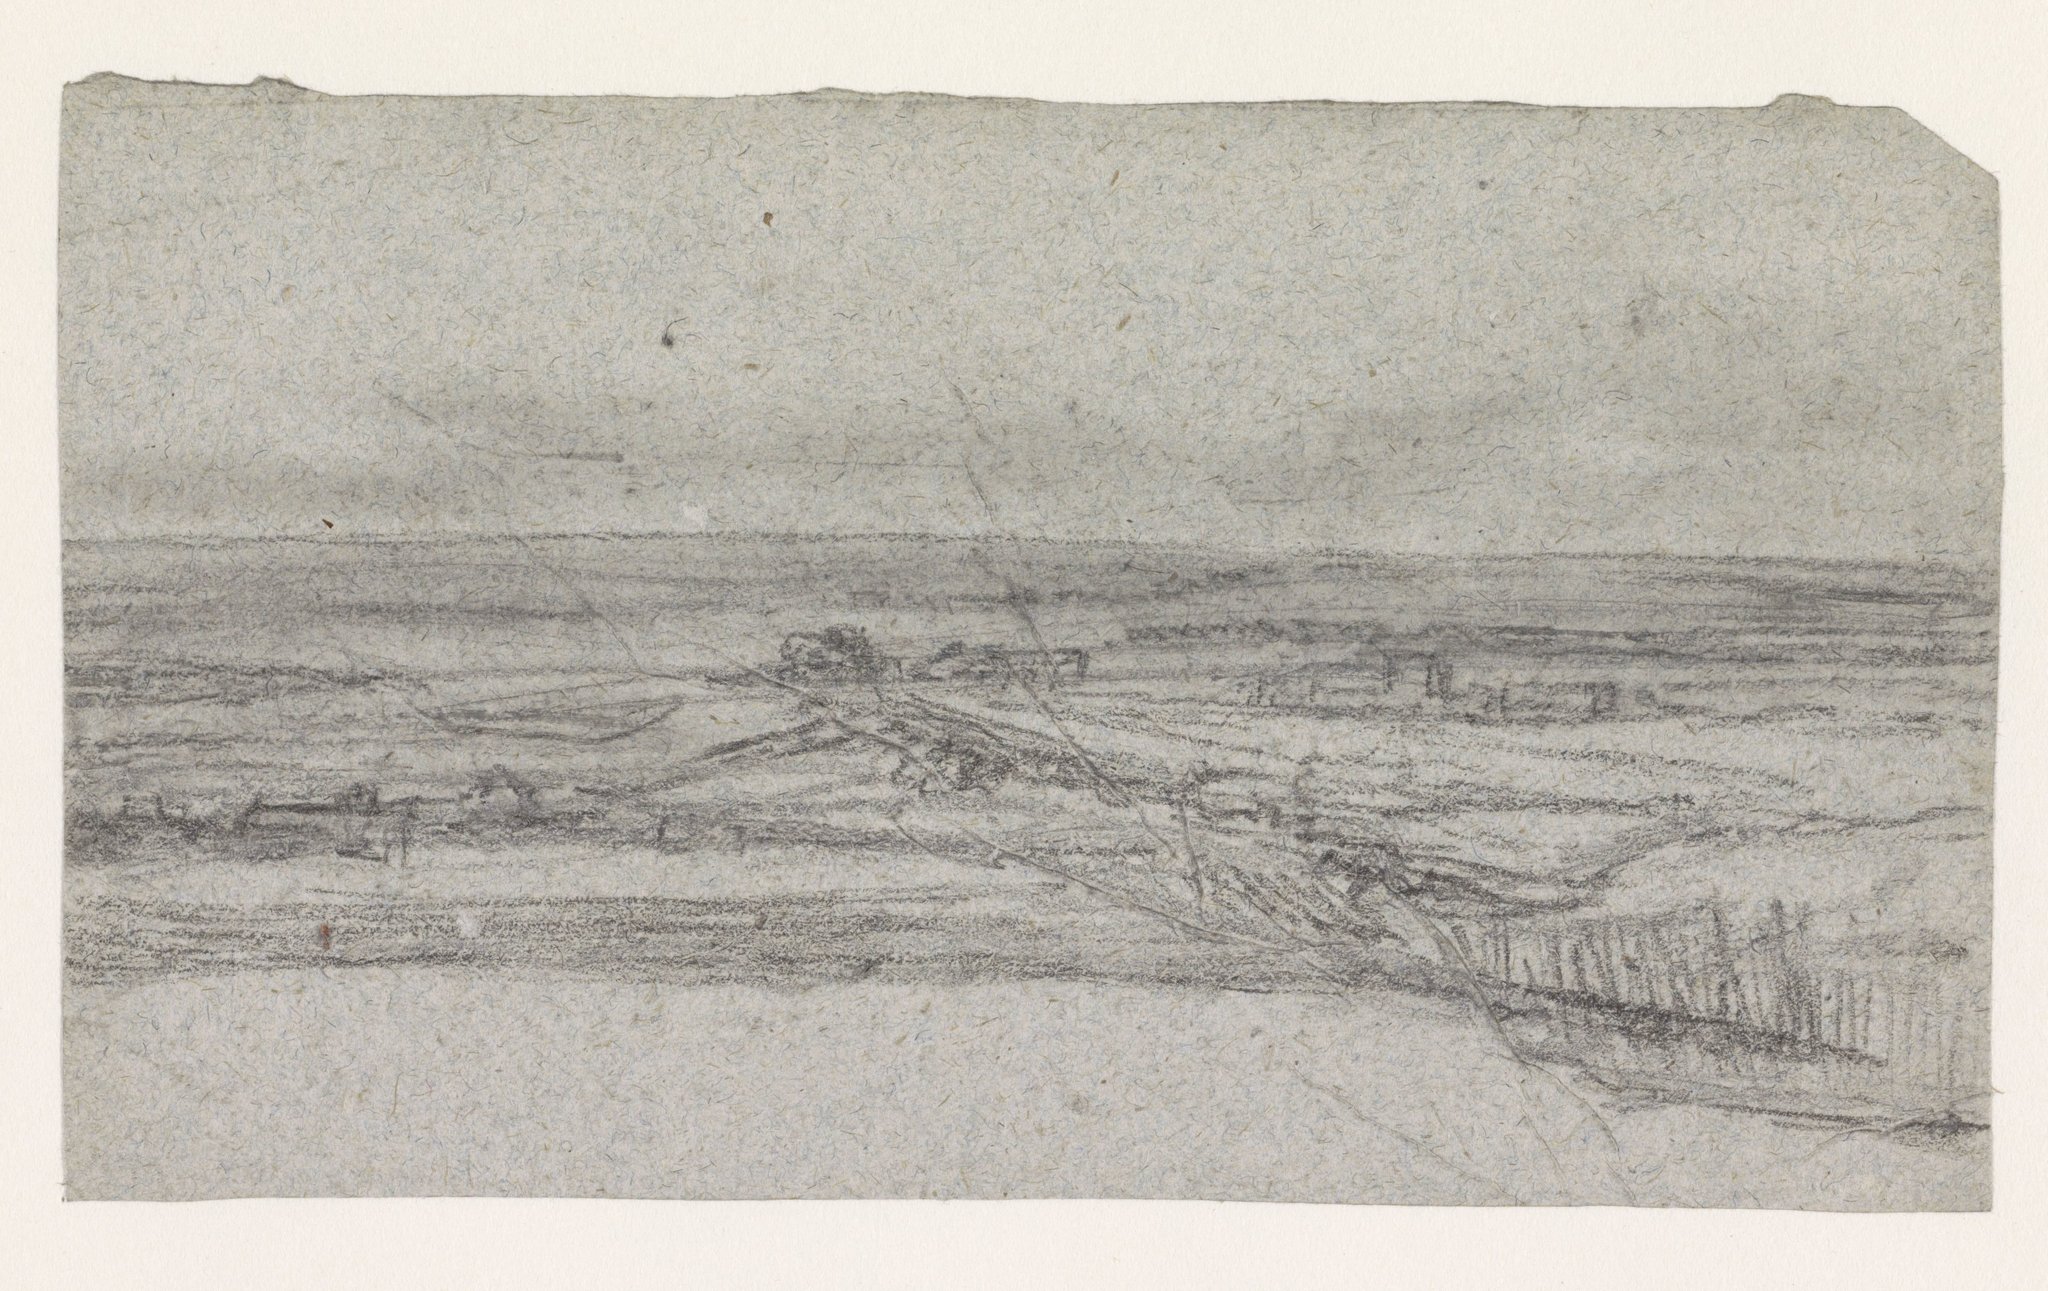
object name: drawing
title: Donker vlak landschap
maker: georges michel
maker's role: draughtsman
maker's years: 1763-1843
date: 1773-1843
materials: chalk, paper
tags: landscapes in the temperate zone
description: Een van 120 tekeningen, afkomstig uit een 19e eeuws album met tekeningen van Georges Michel.